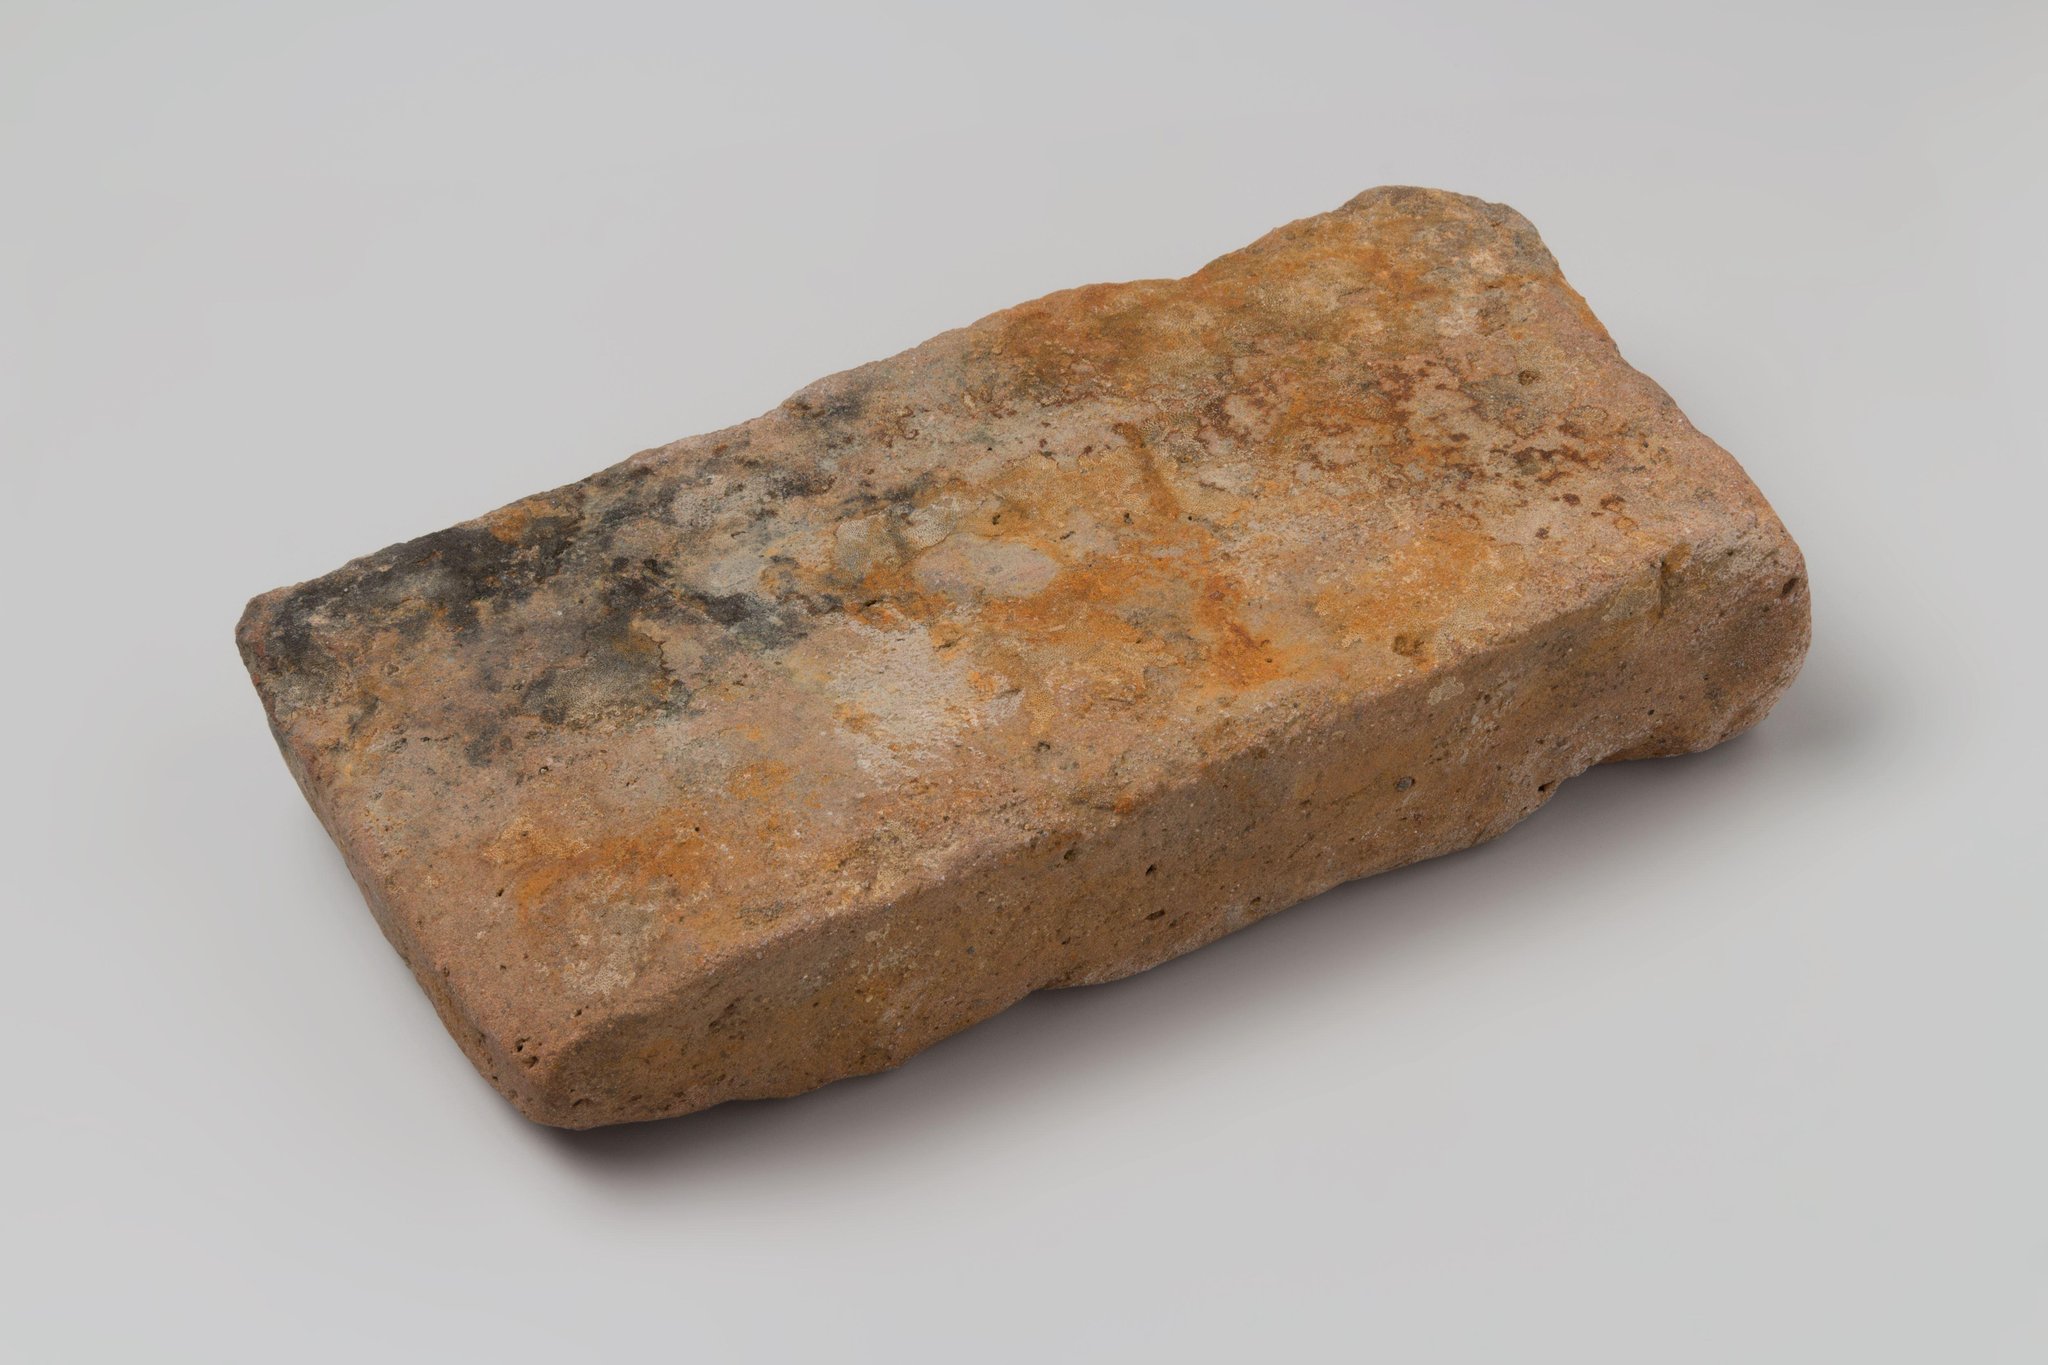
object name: brick clay product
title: Baksteen uit het wrak van de Oost-Indiëvaarder 't Vliegend Hart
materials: brick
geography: netherlands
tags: 't vliegend hart (schip), verenigde oostindische compagnie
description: Hele baksteen, bruinrood, rechthoekig. Brick.